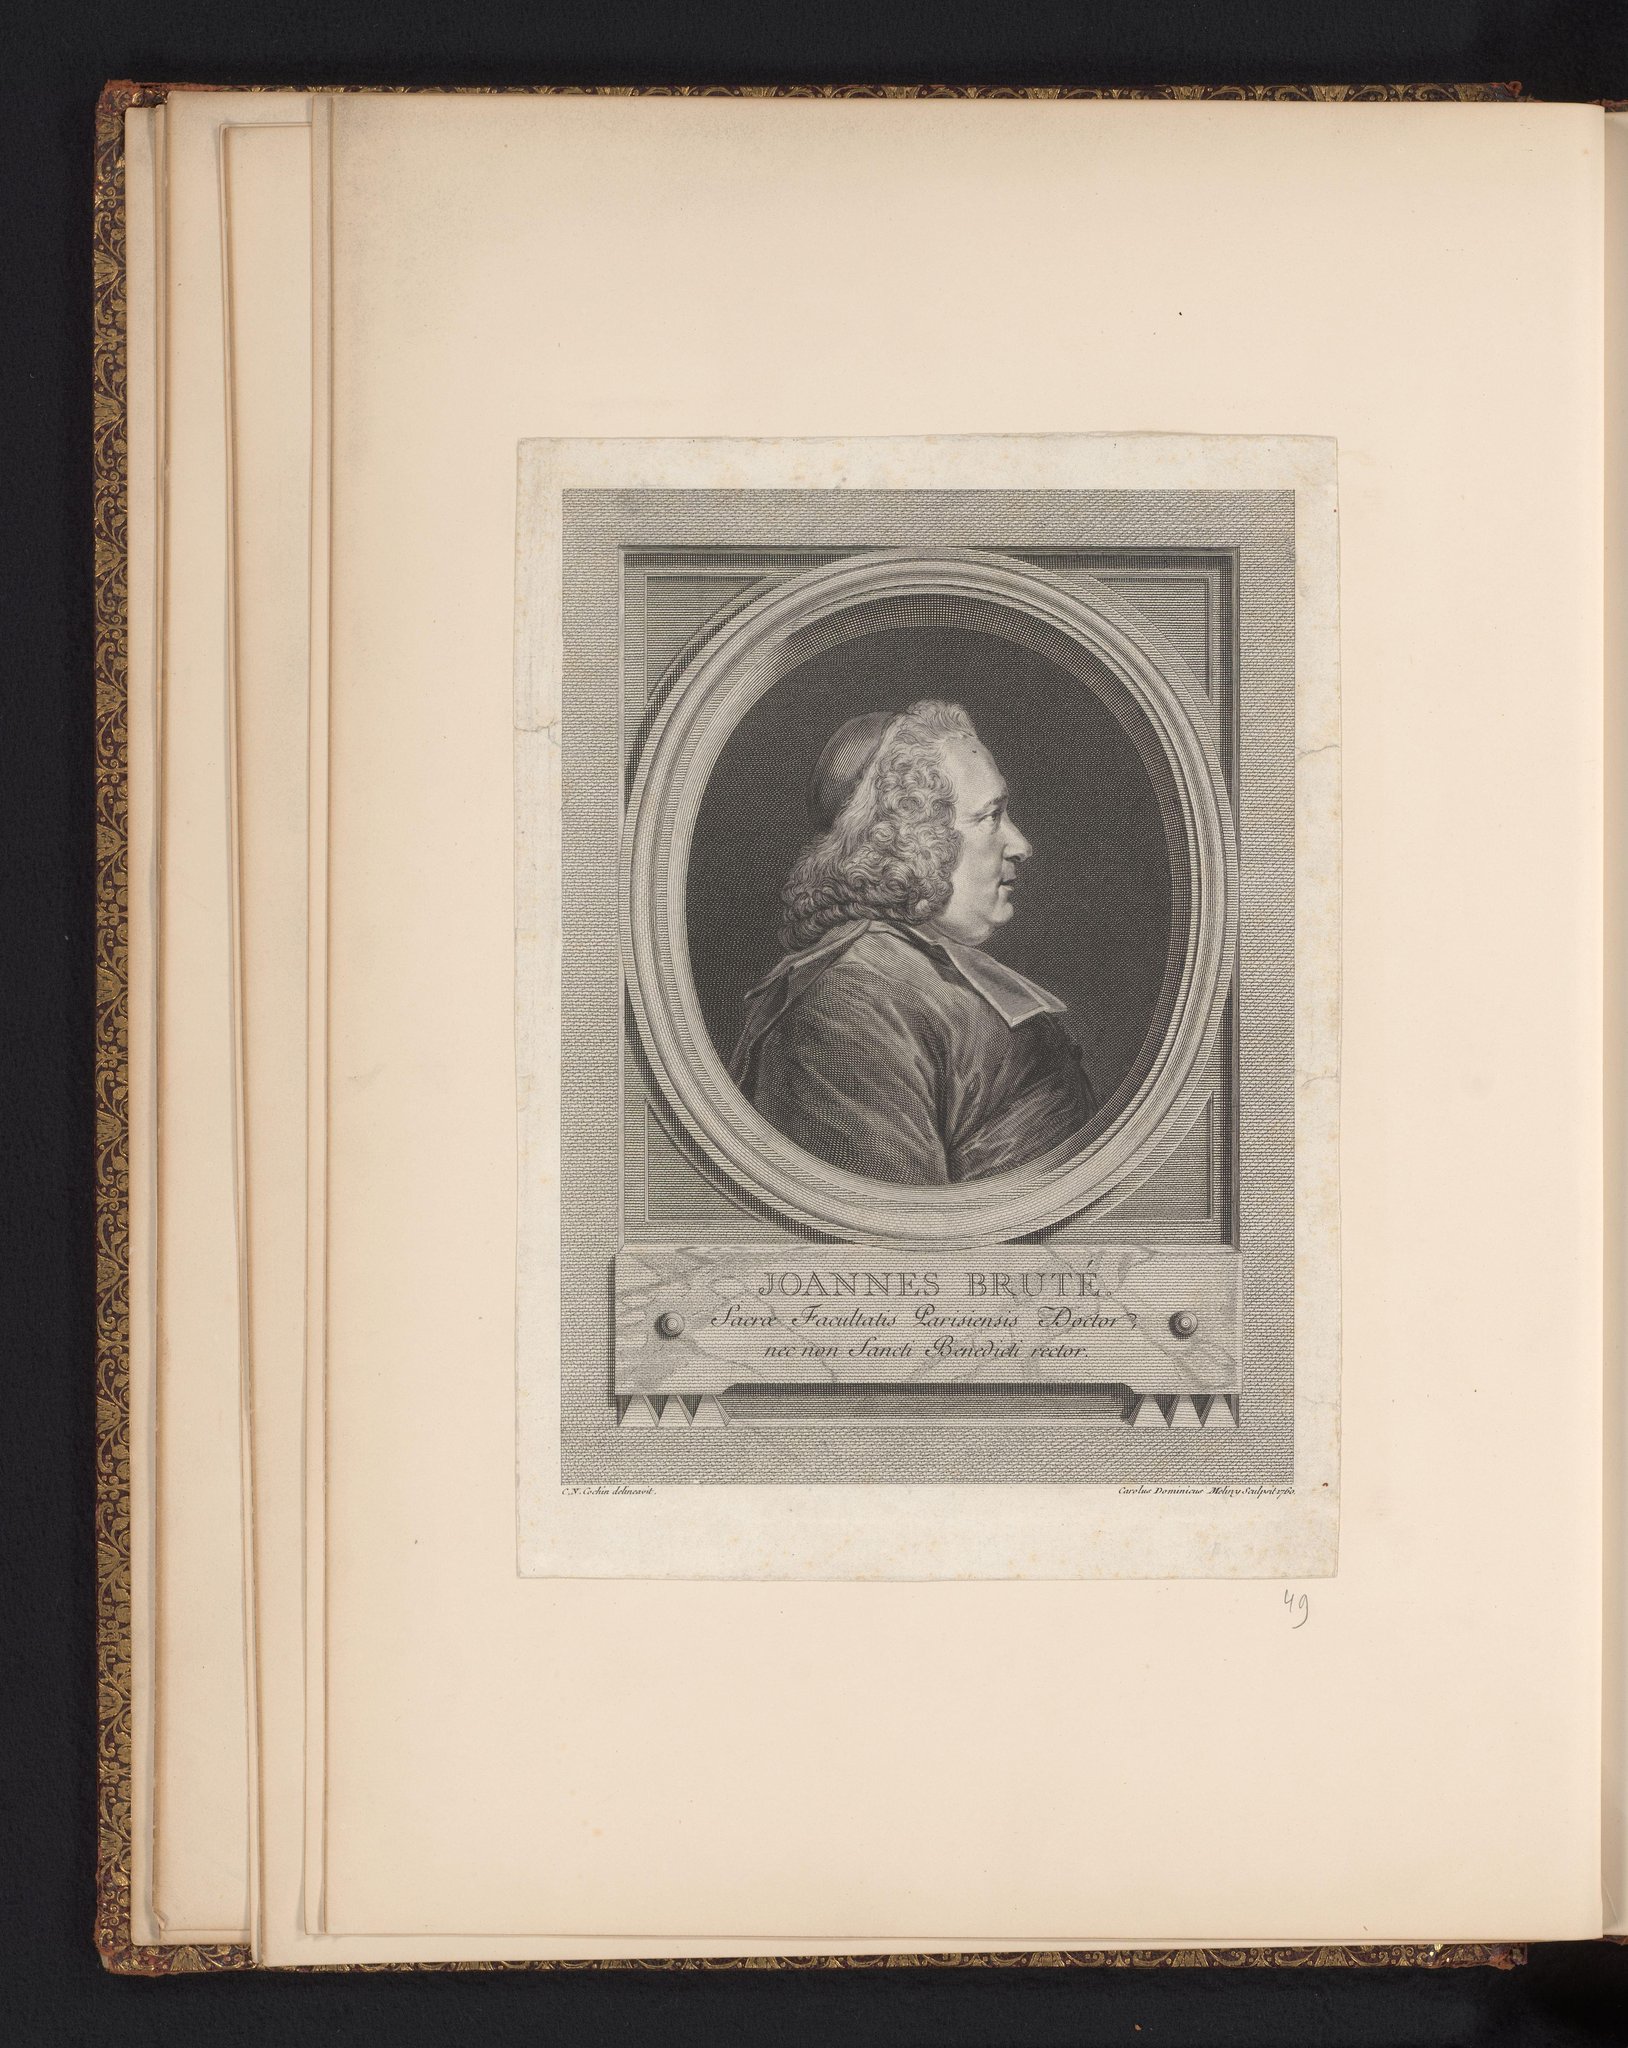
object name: print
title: Portret van Jean Bruté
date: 1760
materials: paper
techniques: engraving, etching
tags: jean bruté, historical persons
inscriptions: date